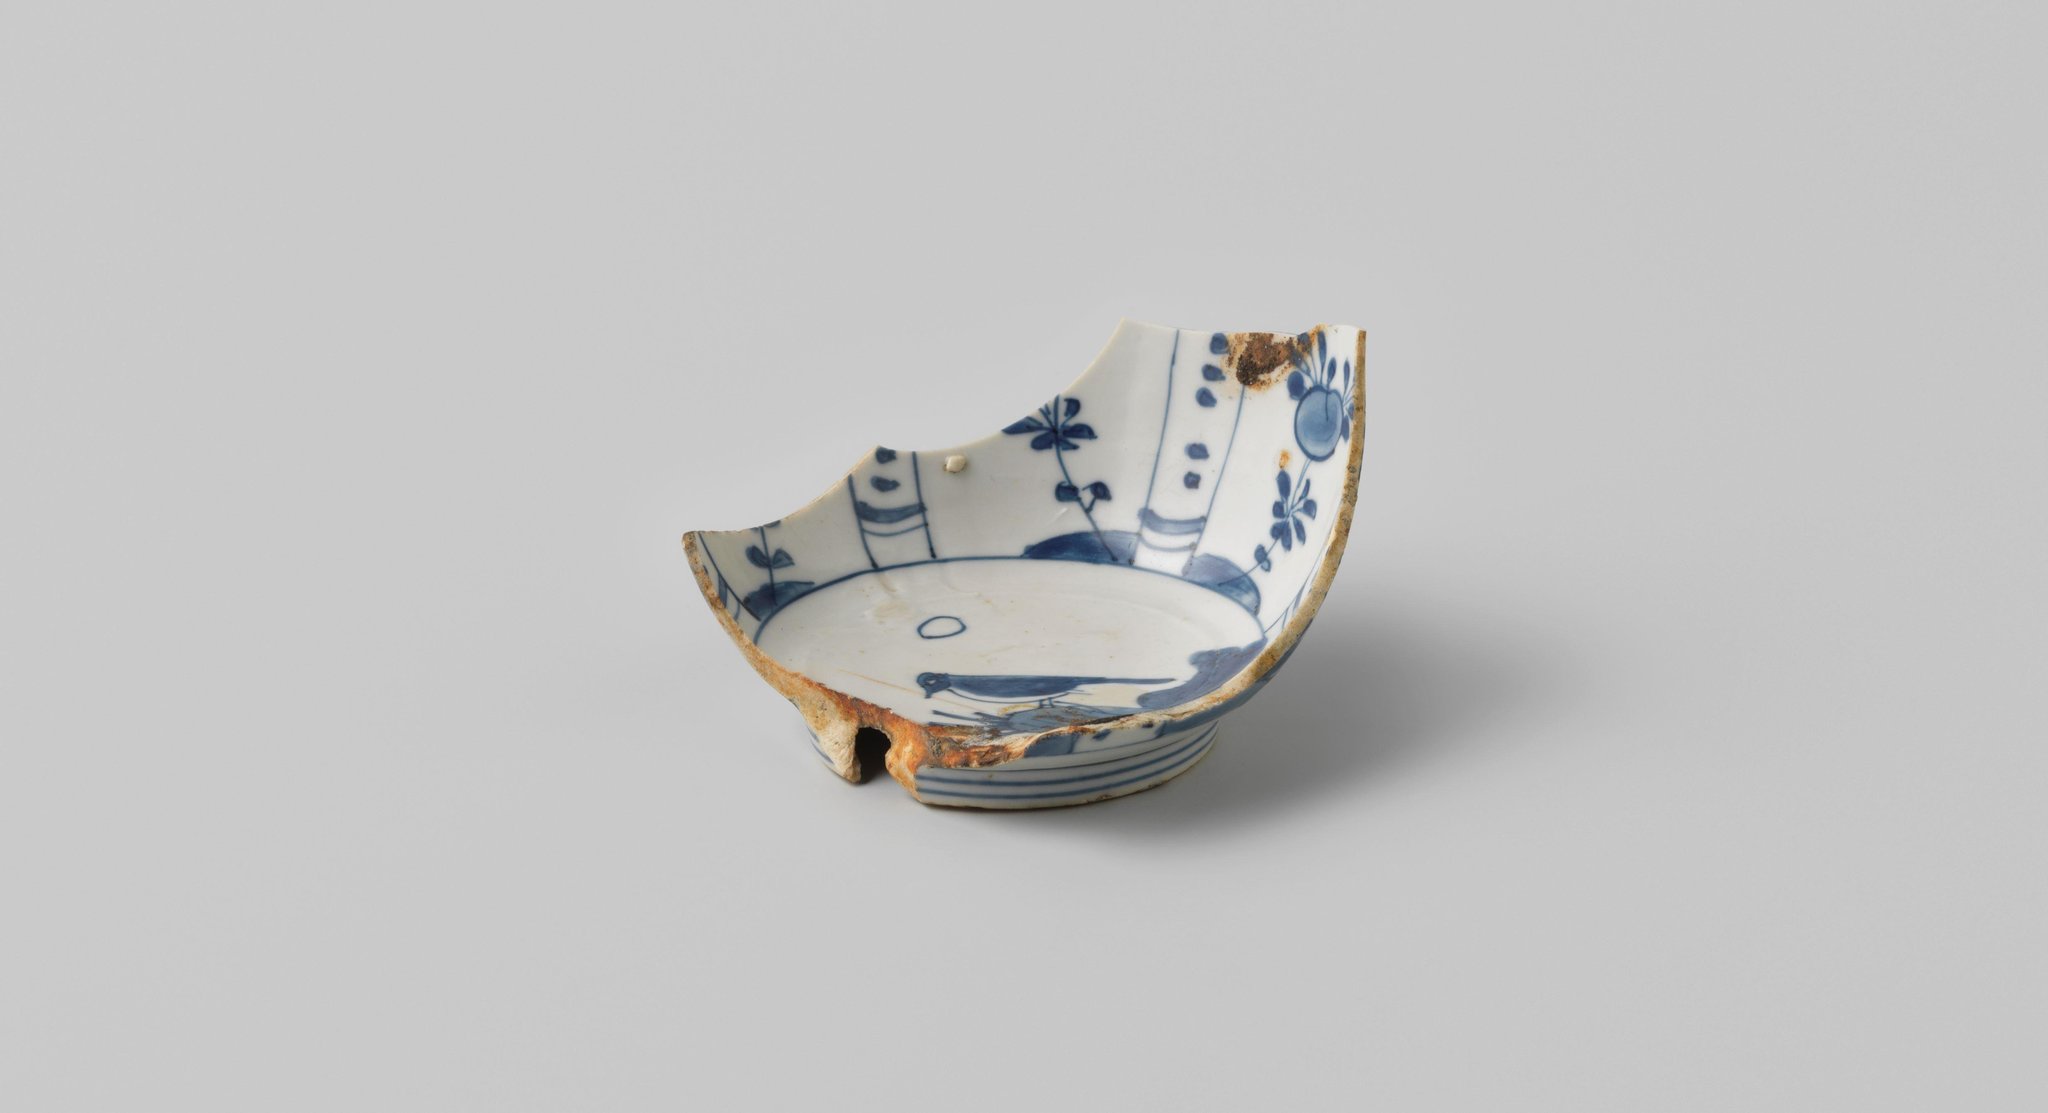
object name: kraaikop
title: Fragment kraaikop uit V.O.C.-schip de 'Witte Leeuw'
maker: Anonymous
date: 1613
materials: bone china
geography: jingdezhen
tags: verenigde oostindische compagnie, sint-helena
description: A high bowl. The inside decorated with flower- and fruit-sprays. The exterior with flowers, a cicada and birds.